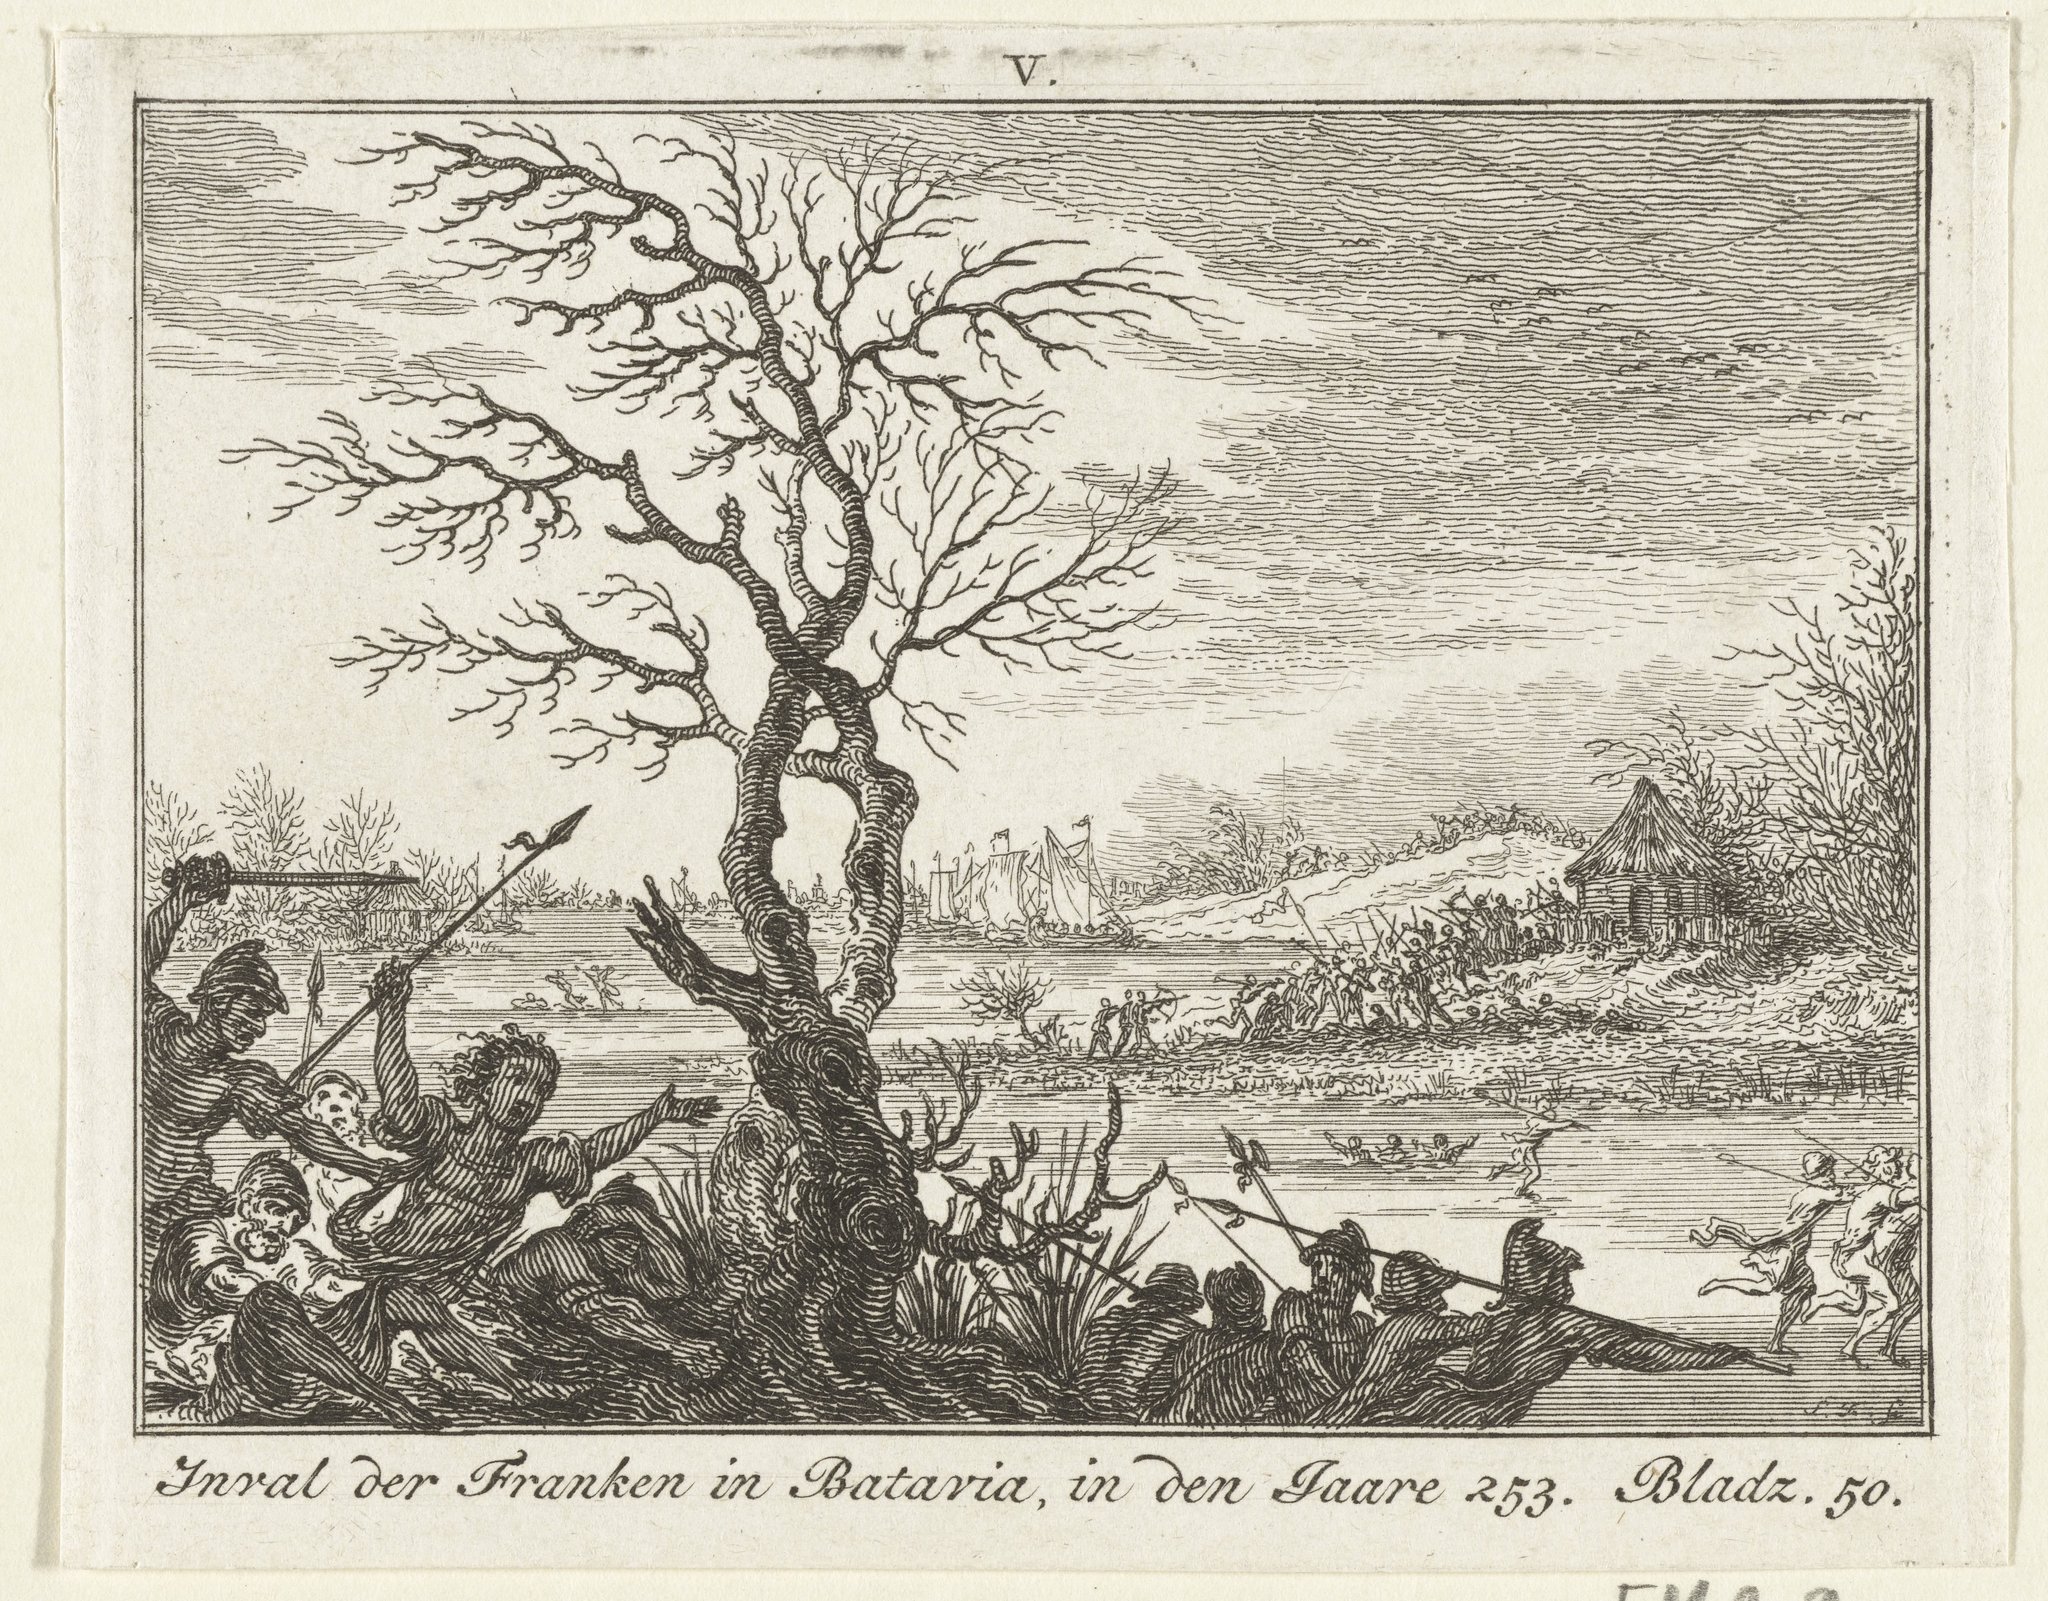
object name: print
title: De Franken vallen het land van de Bataven binnen, 253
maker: simon fokke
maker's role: draughtsman, print maker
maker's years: 1712-1784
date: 1722-1750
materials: paper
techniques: etching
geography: northern netherlands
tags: extinct, 'historical' peoples (with name), netherlands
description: Illustratie voor een onbekend werk, later hergebruikt in: J.W. te Water, De vaderlandsche Historie van den heere J. Wagenaar, verkort, en met leerzaame aanmerkingen, ten dienste der Nederlandsche jeugd, 1784-1800, 4 delen. Bovenaan: V., onderaan: bladz. 50. Staat met de letter.